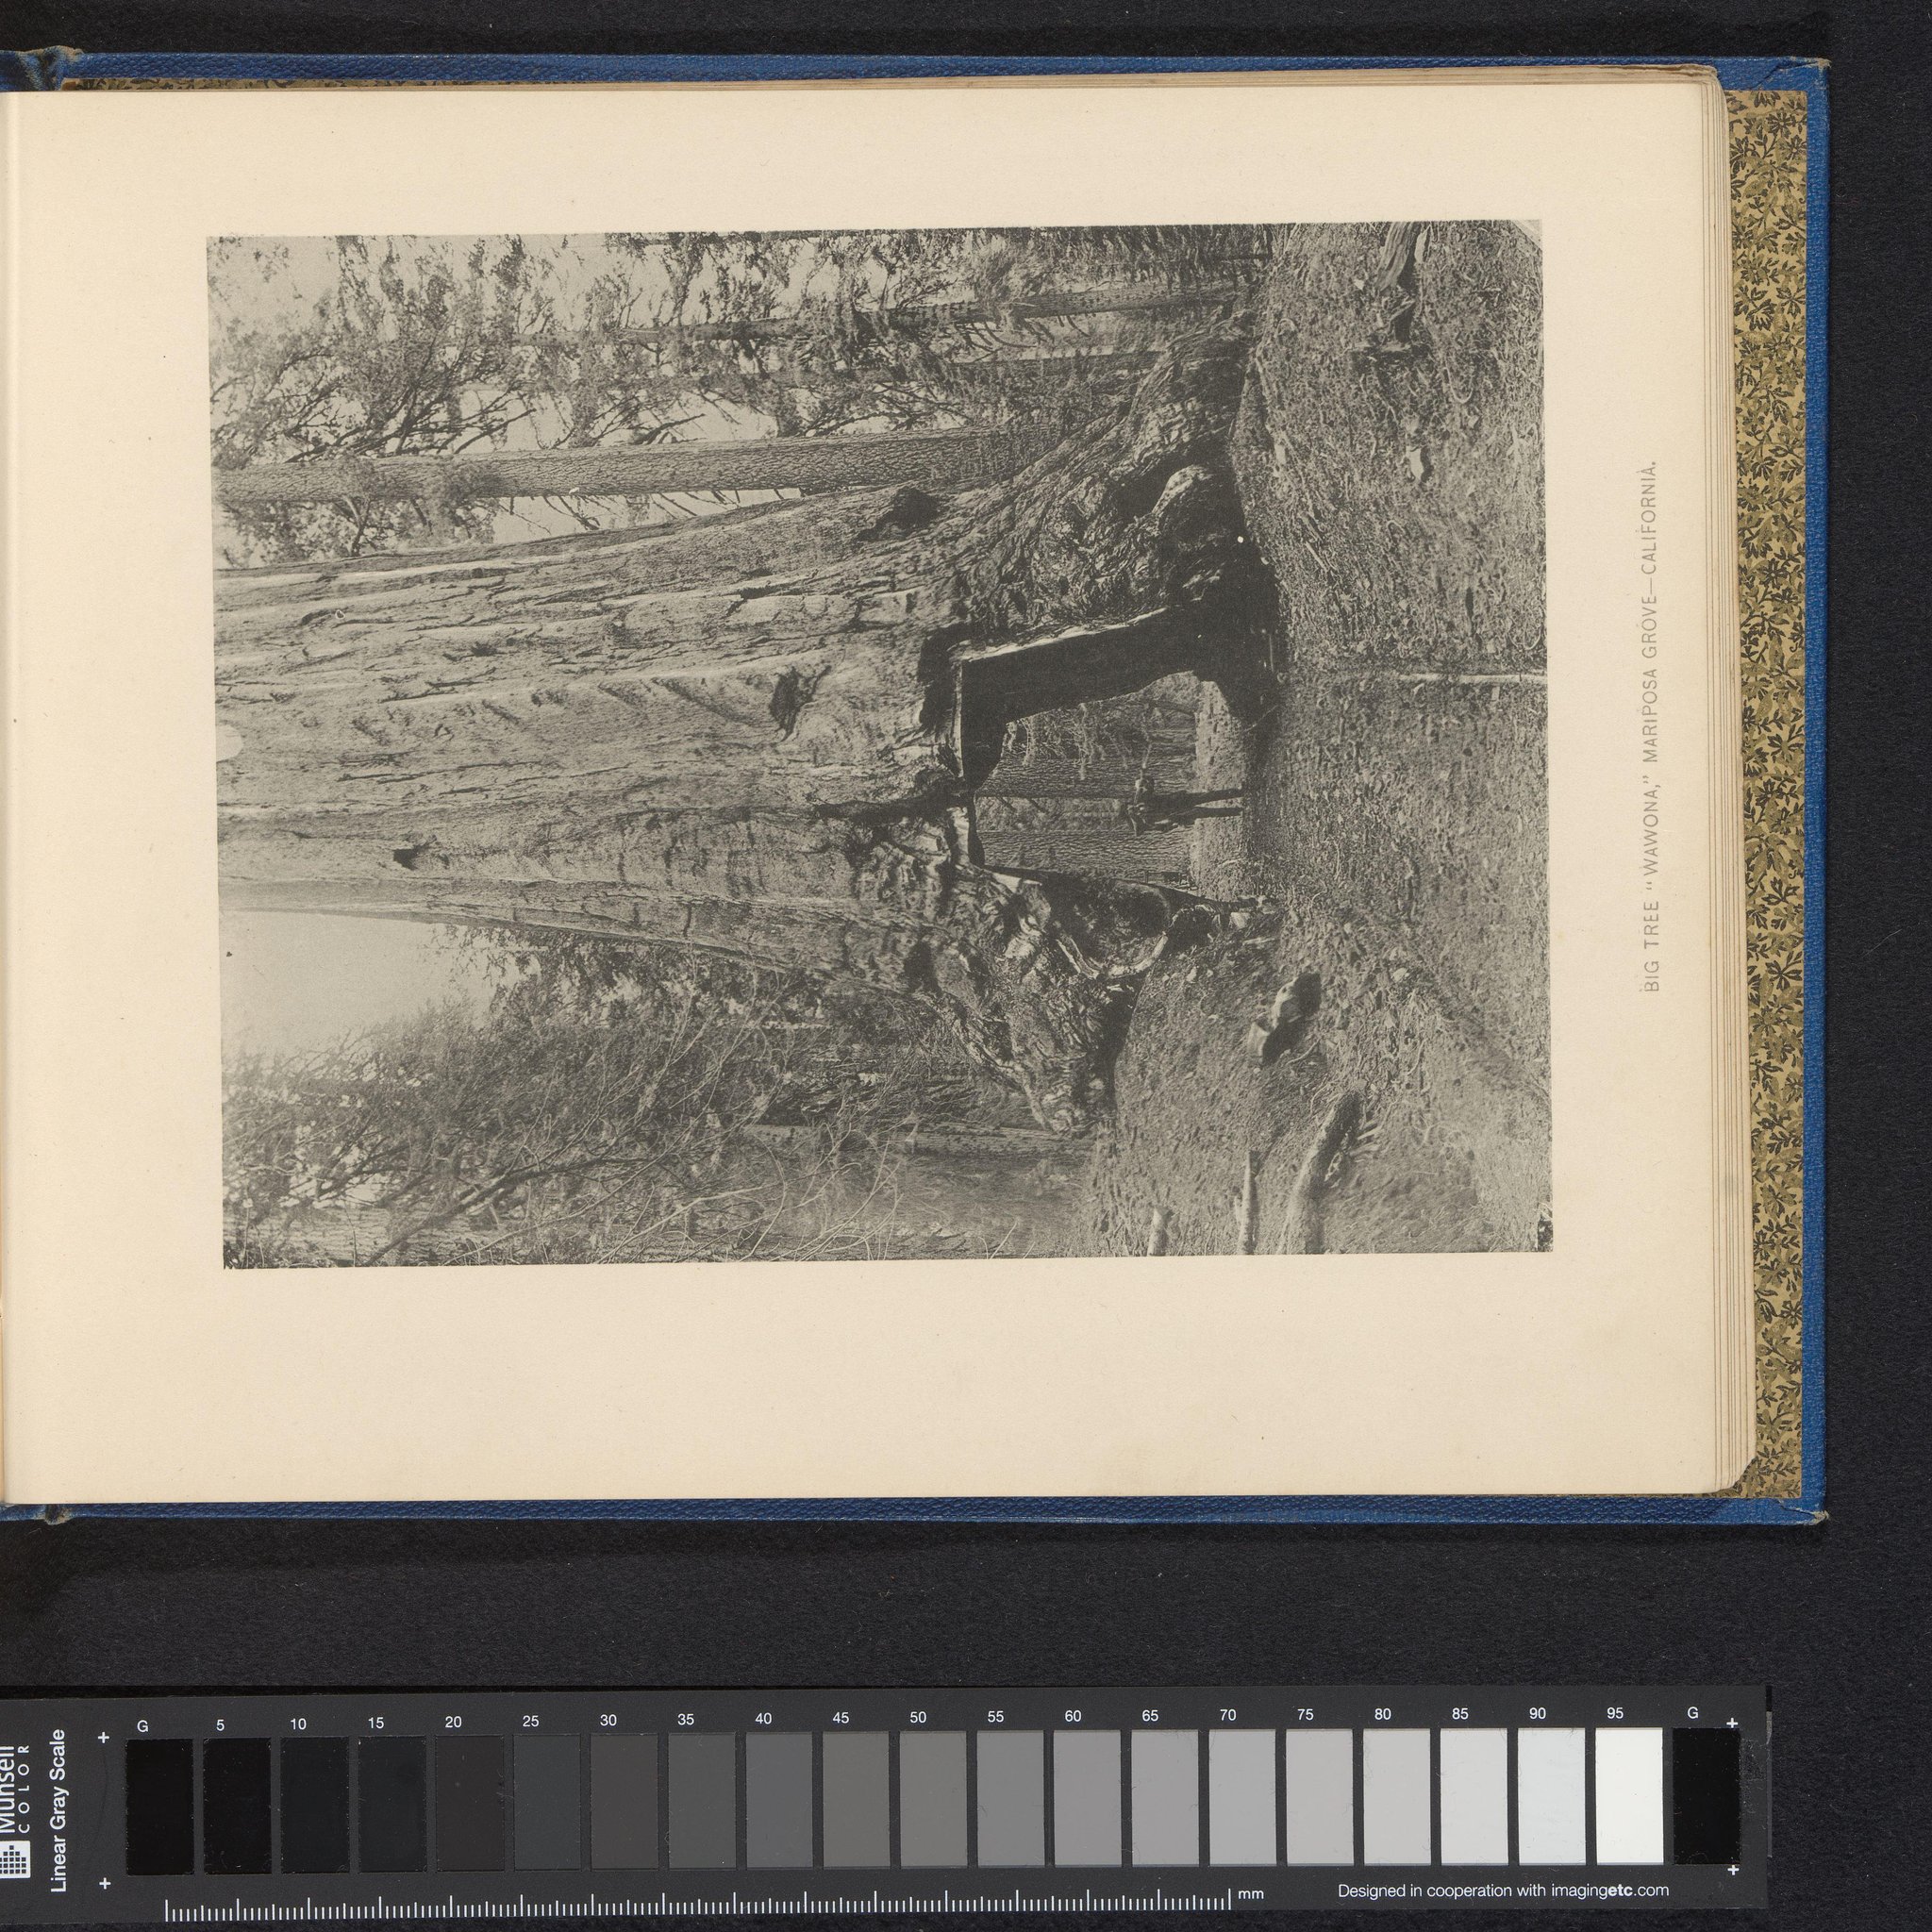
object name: page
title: Gezicht op de Wawona Tree in de Mariposa Grove met een man met een geweer in de tunnel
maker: Anonymous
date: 1883-1893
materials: paper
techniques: photograph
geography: mariposa grove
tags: trees, firearms: rifle